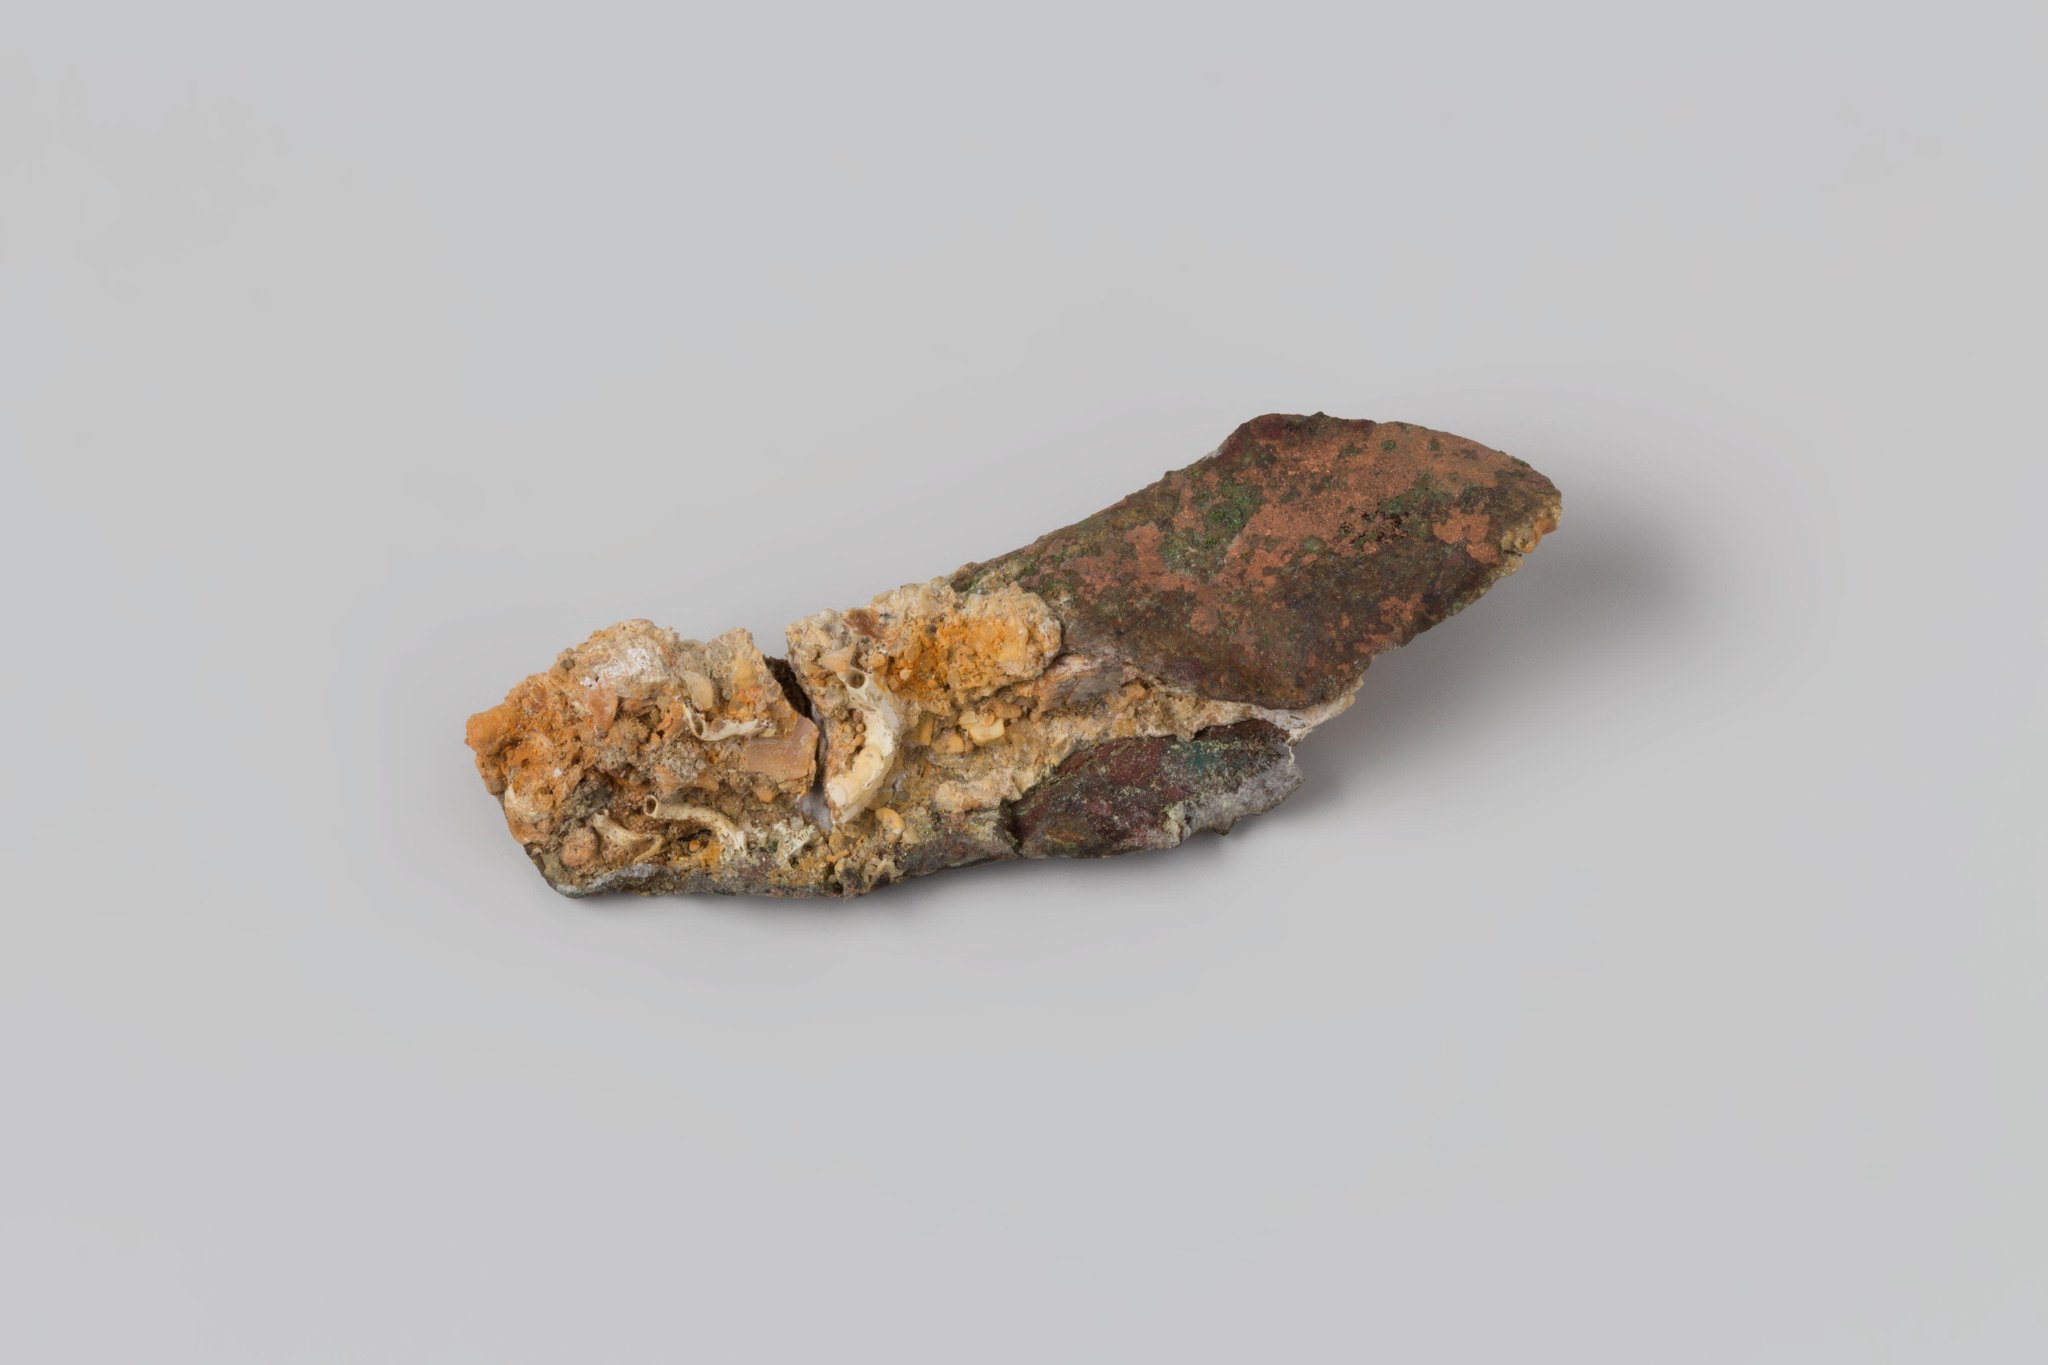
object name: scheepswrakvondst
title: Fragment van koper uit het wrak van de Oost-Indiëvaarder Hollandia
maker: Anonymous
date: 1700-1743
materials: copper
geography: netherlands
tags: verenigde oostindische compagnie, hollandia (schip), annet